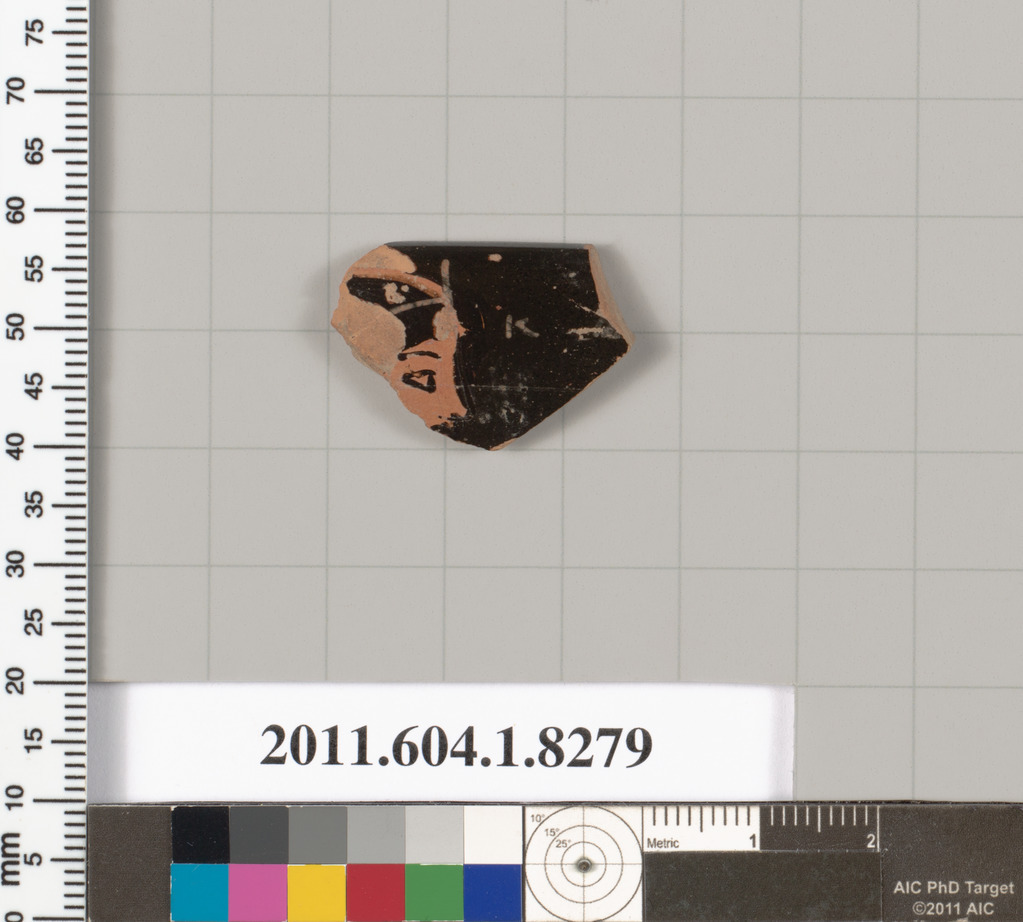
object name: kylix fragment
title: Terracotta rim fragment of a kylix (drinking cup)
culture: greek, attic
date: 434-368 BCE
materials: terracotta